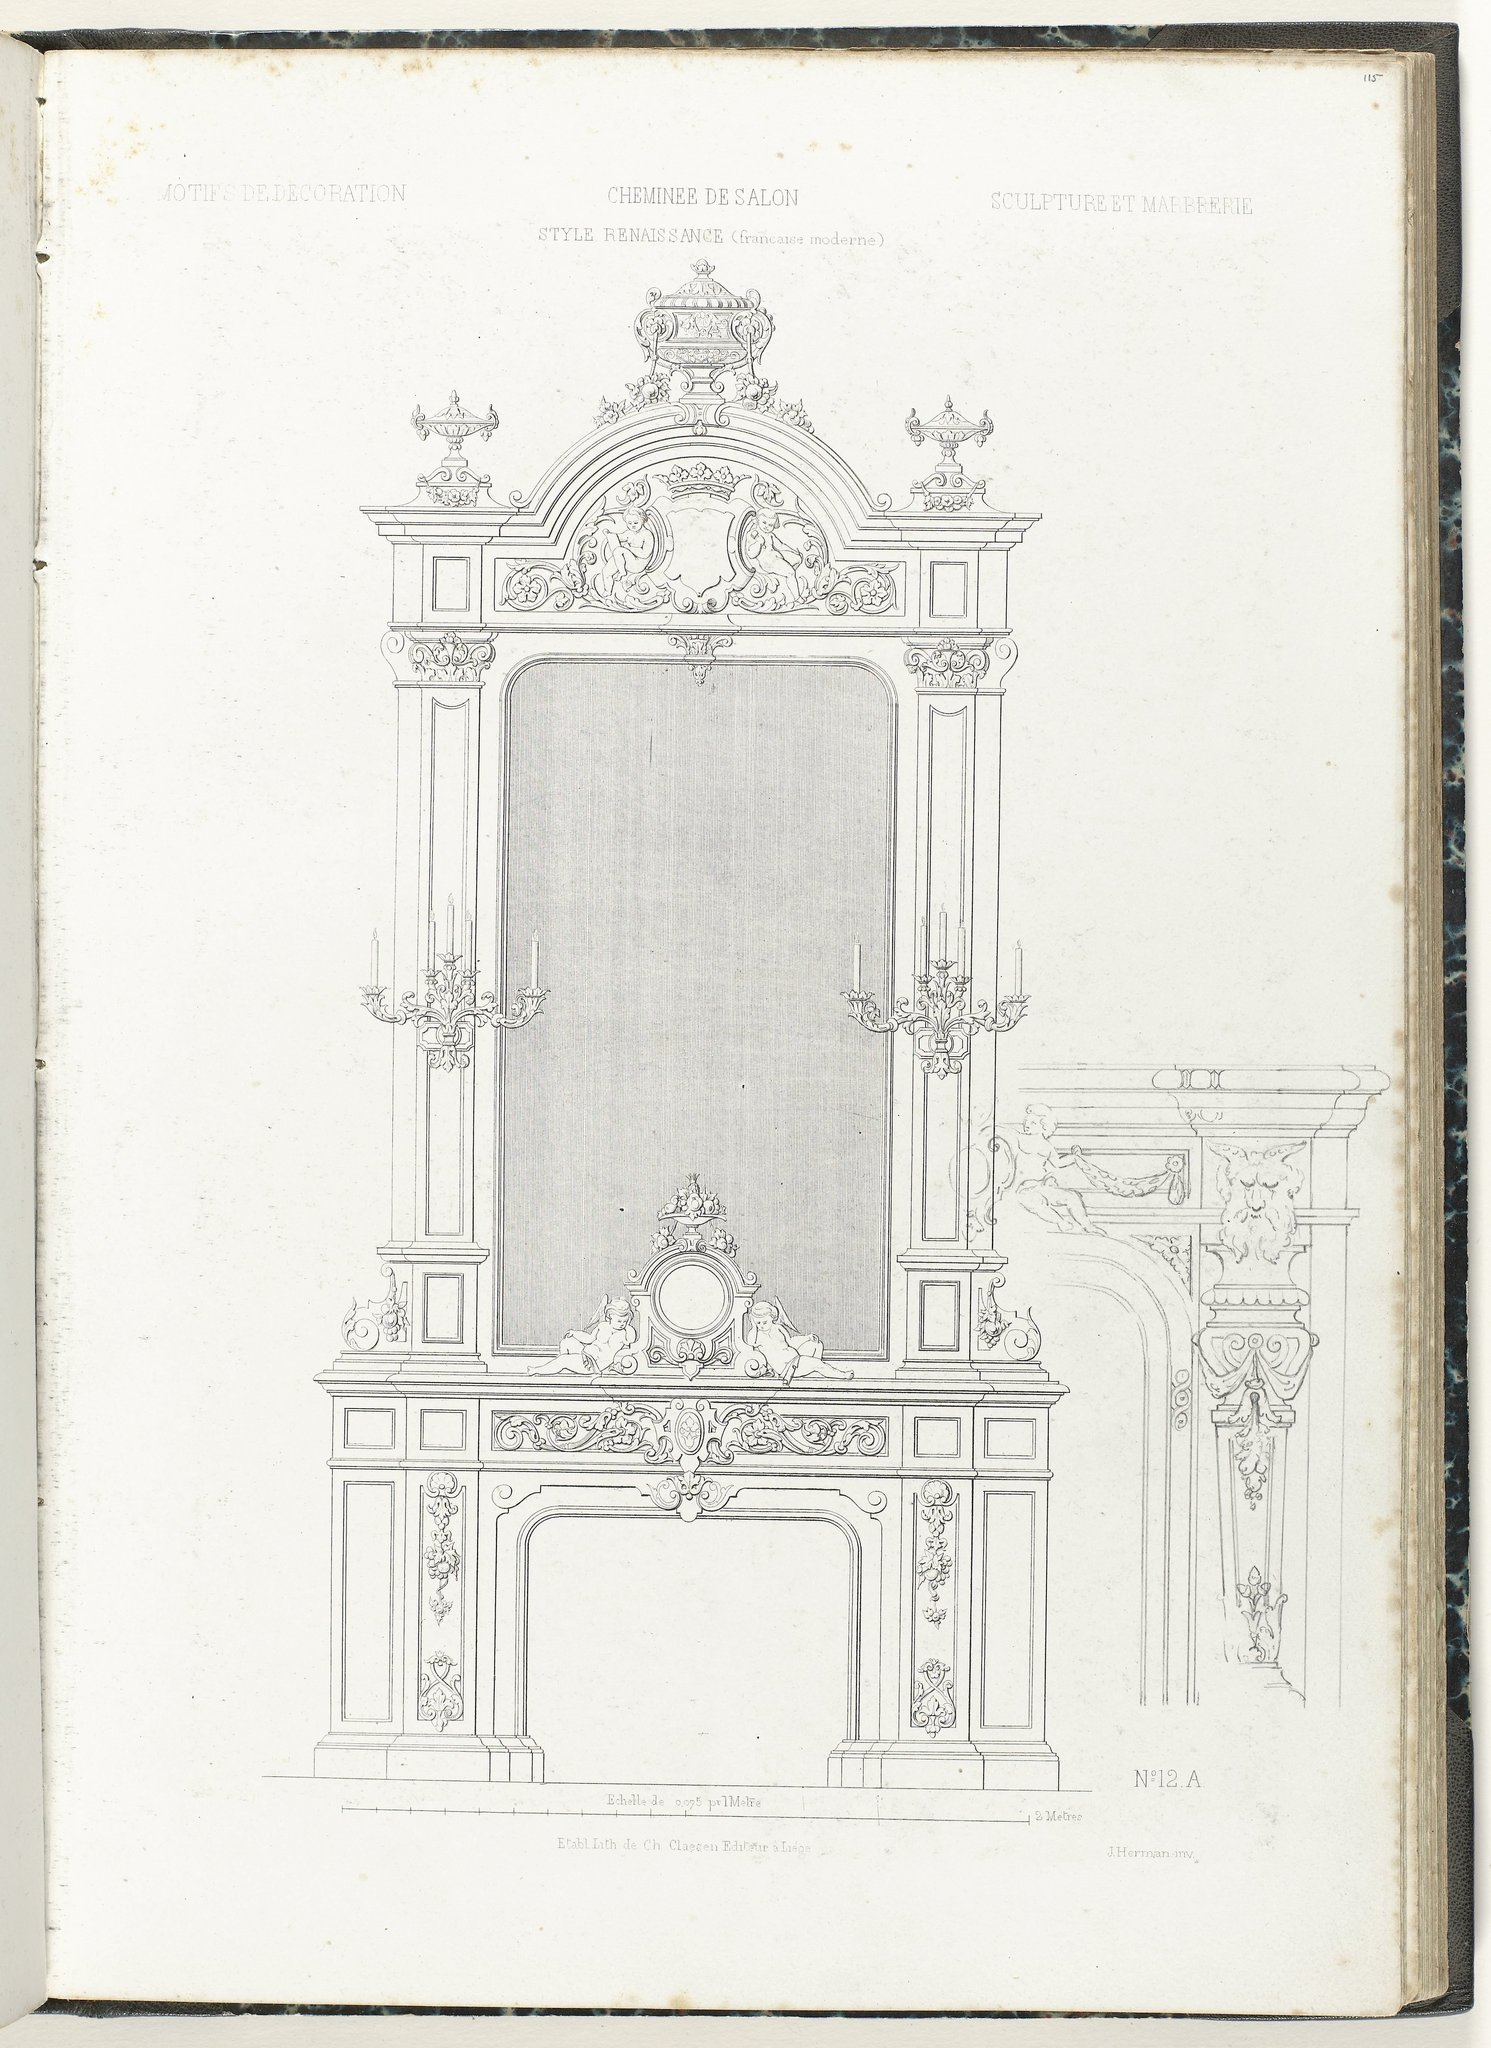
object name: drawing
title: Twee onderboezems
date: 1866-1900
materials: paper, pencil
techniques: drawing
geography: liège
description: Op de schoorsteenplaat staat een klok met aan weerszijden een liggende putto, bovenaan bevindt zich een bekroond schild tussen twee putti. Rechts is een gedeelte van een onderboezem getekend met een putto bovenaan die een guirlande vasthoudt. Rechtsonder staat vermeld: N° 12.A.